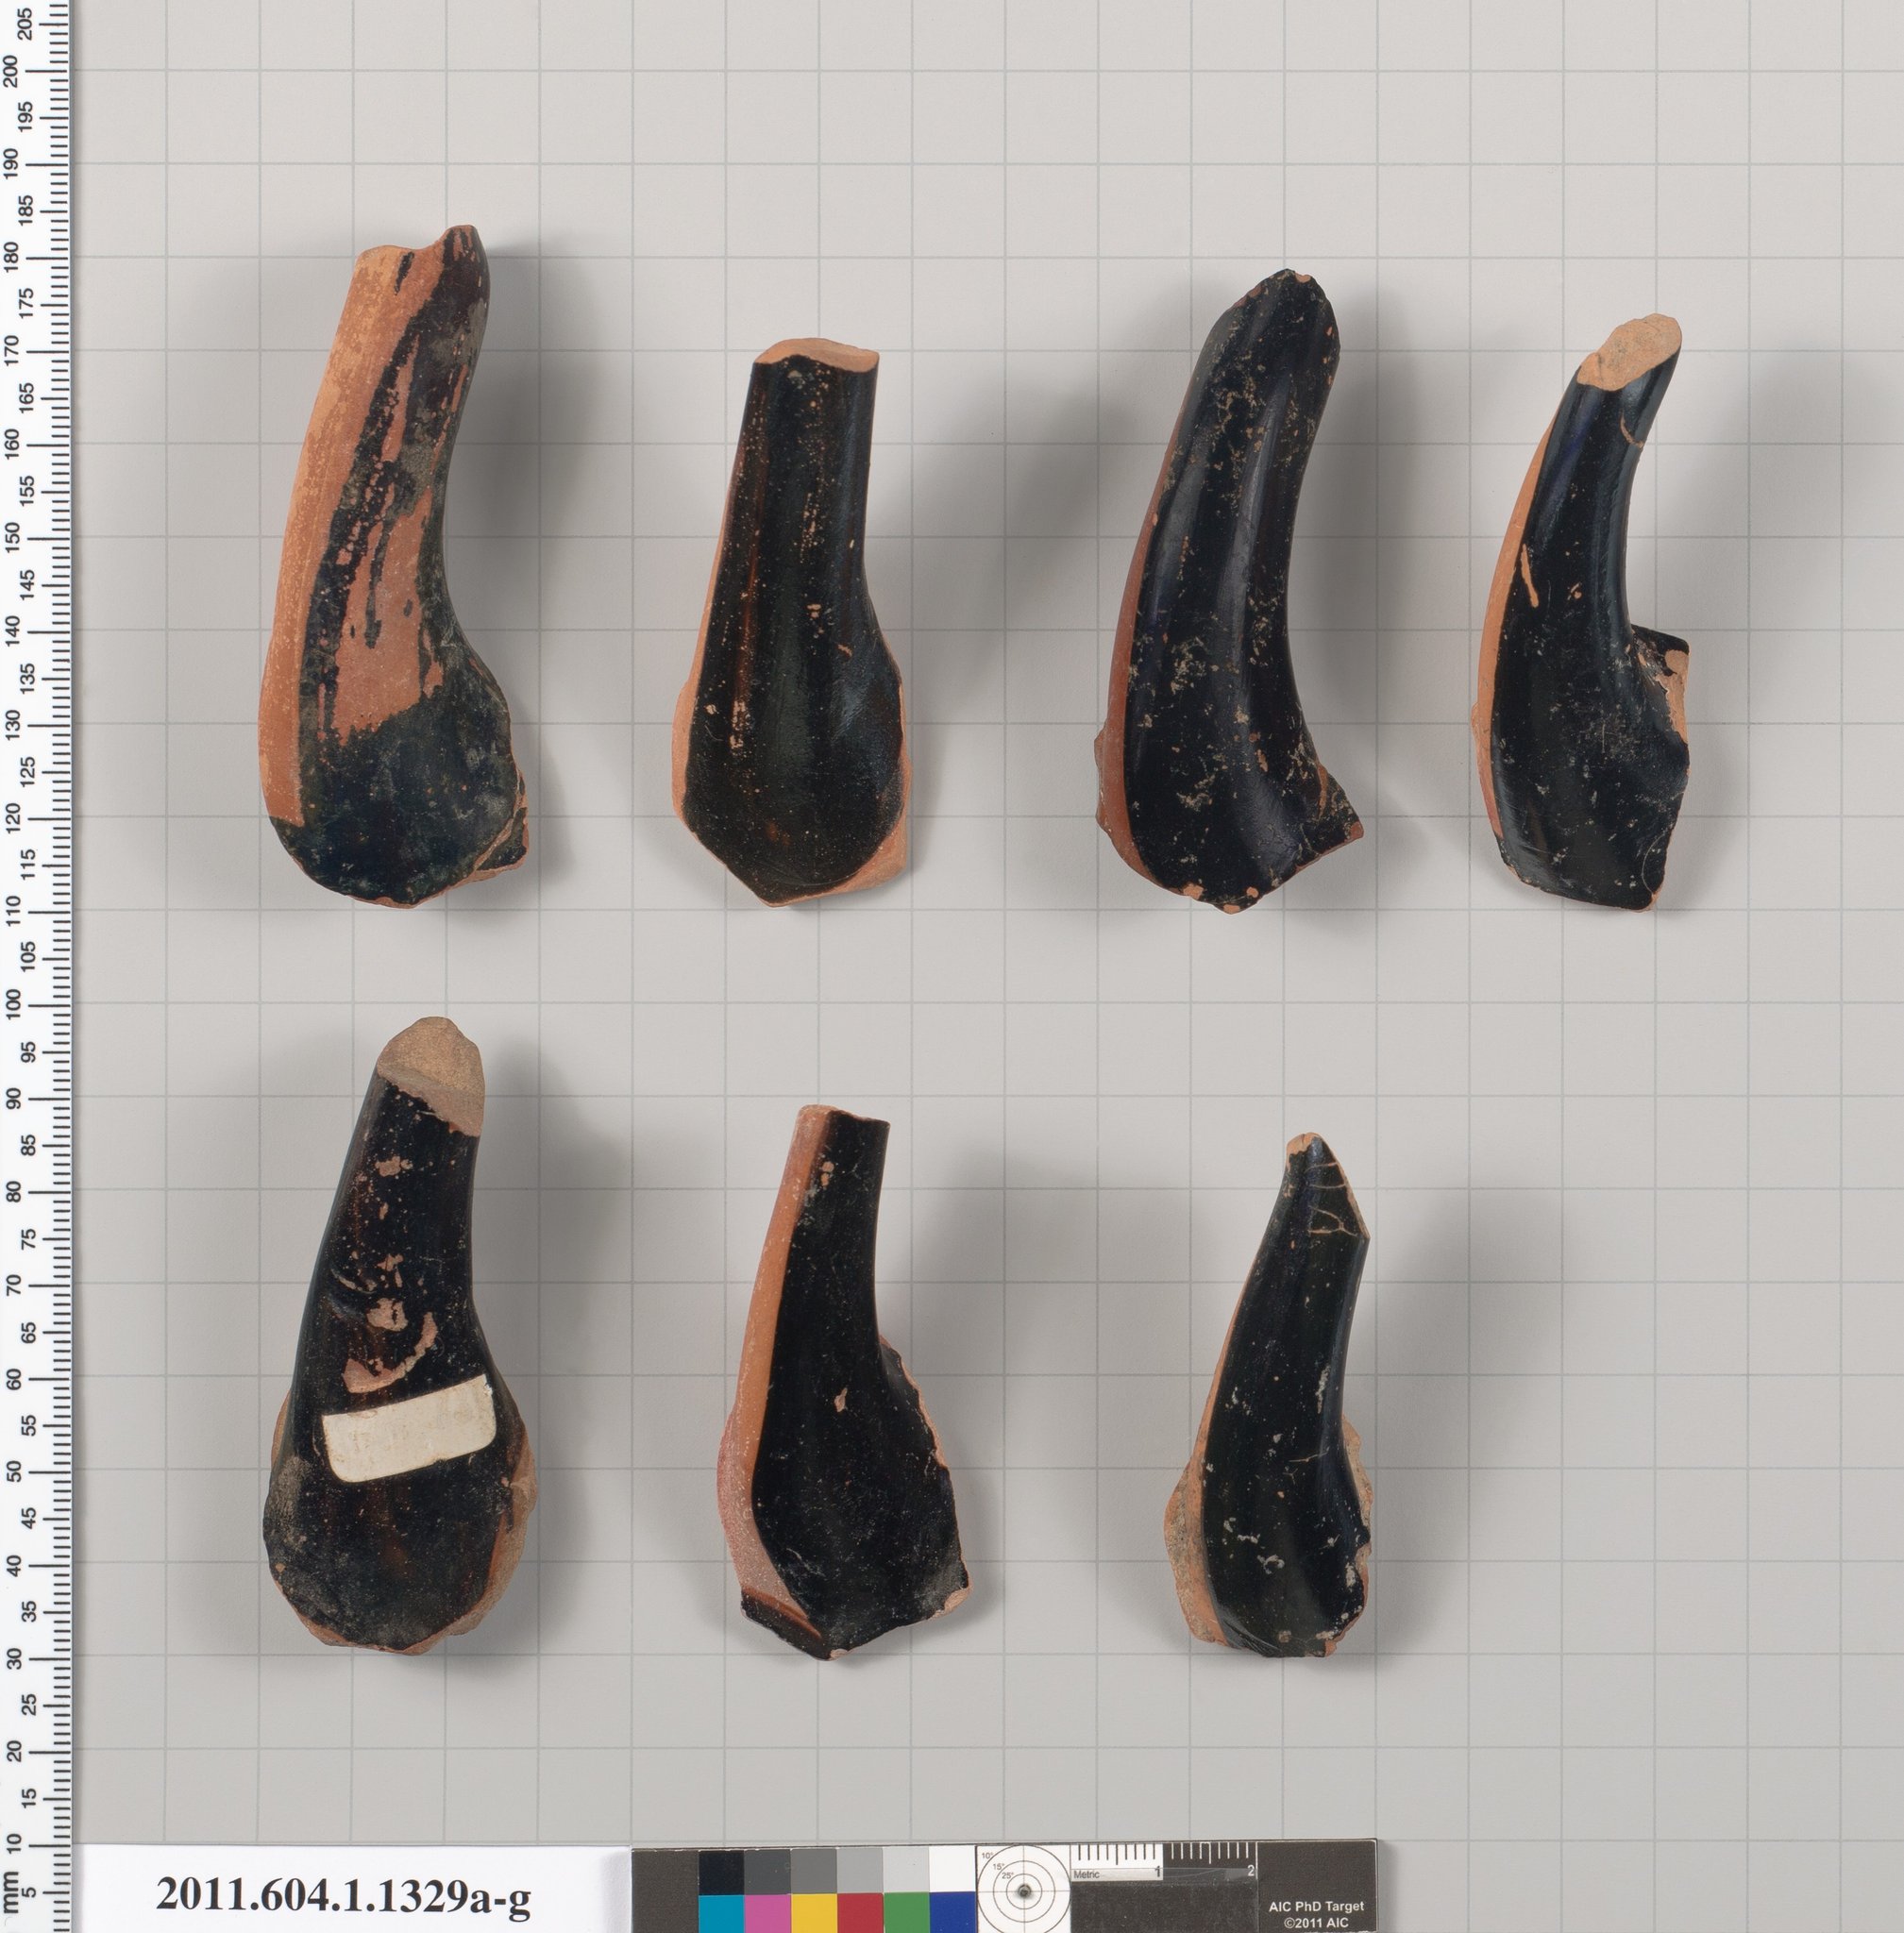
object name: kylix fragment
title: Terracotta fragments of kylikes (drinking cups)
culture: greek, attic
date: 500-401 BCE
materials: terracotta